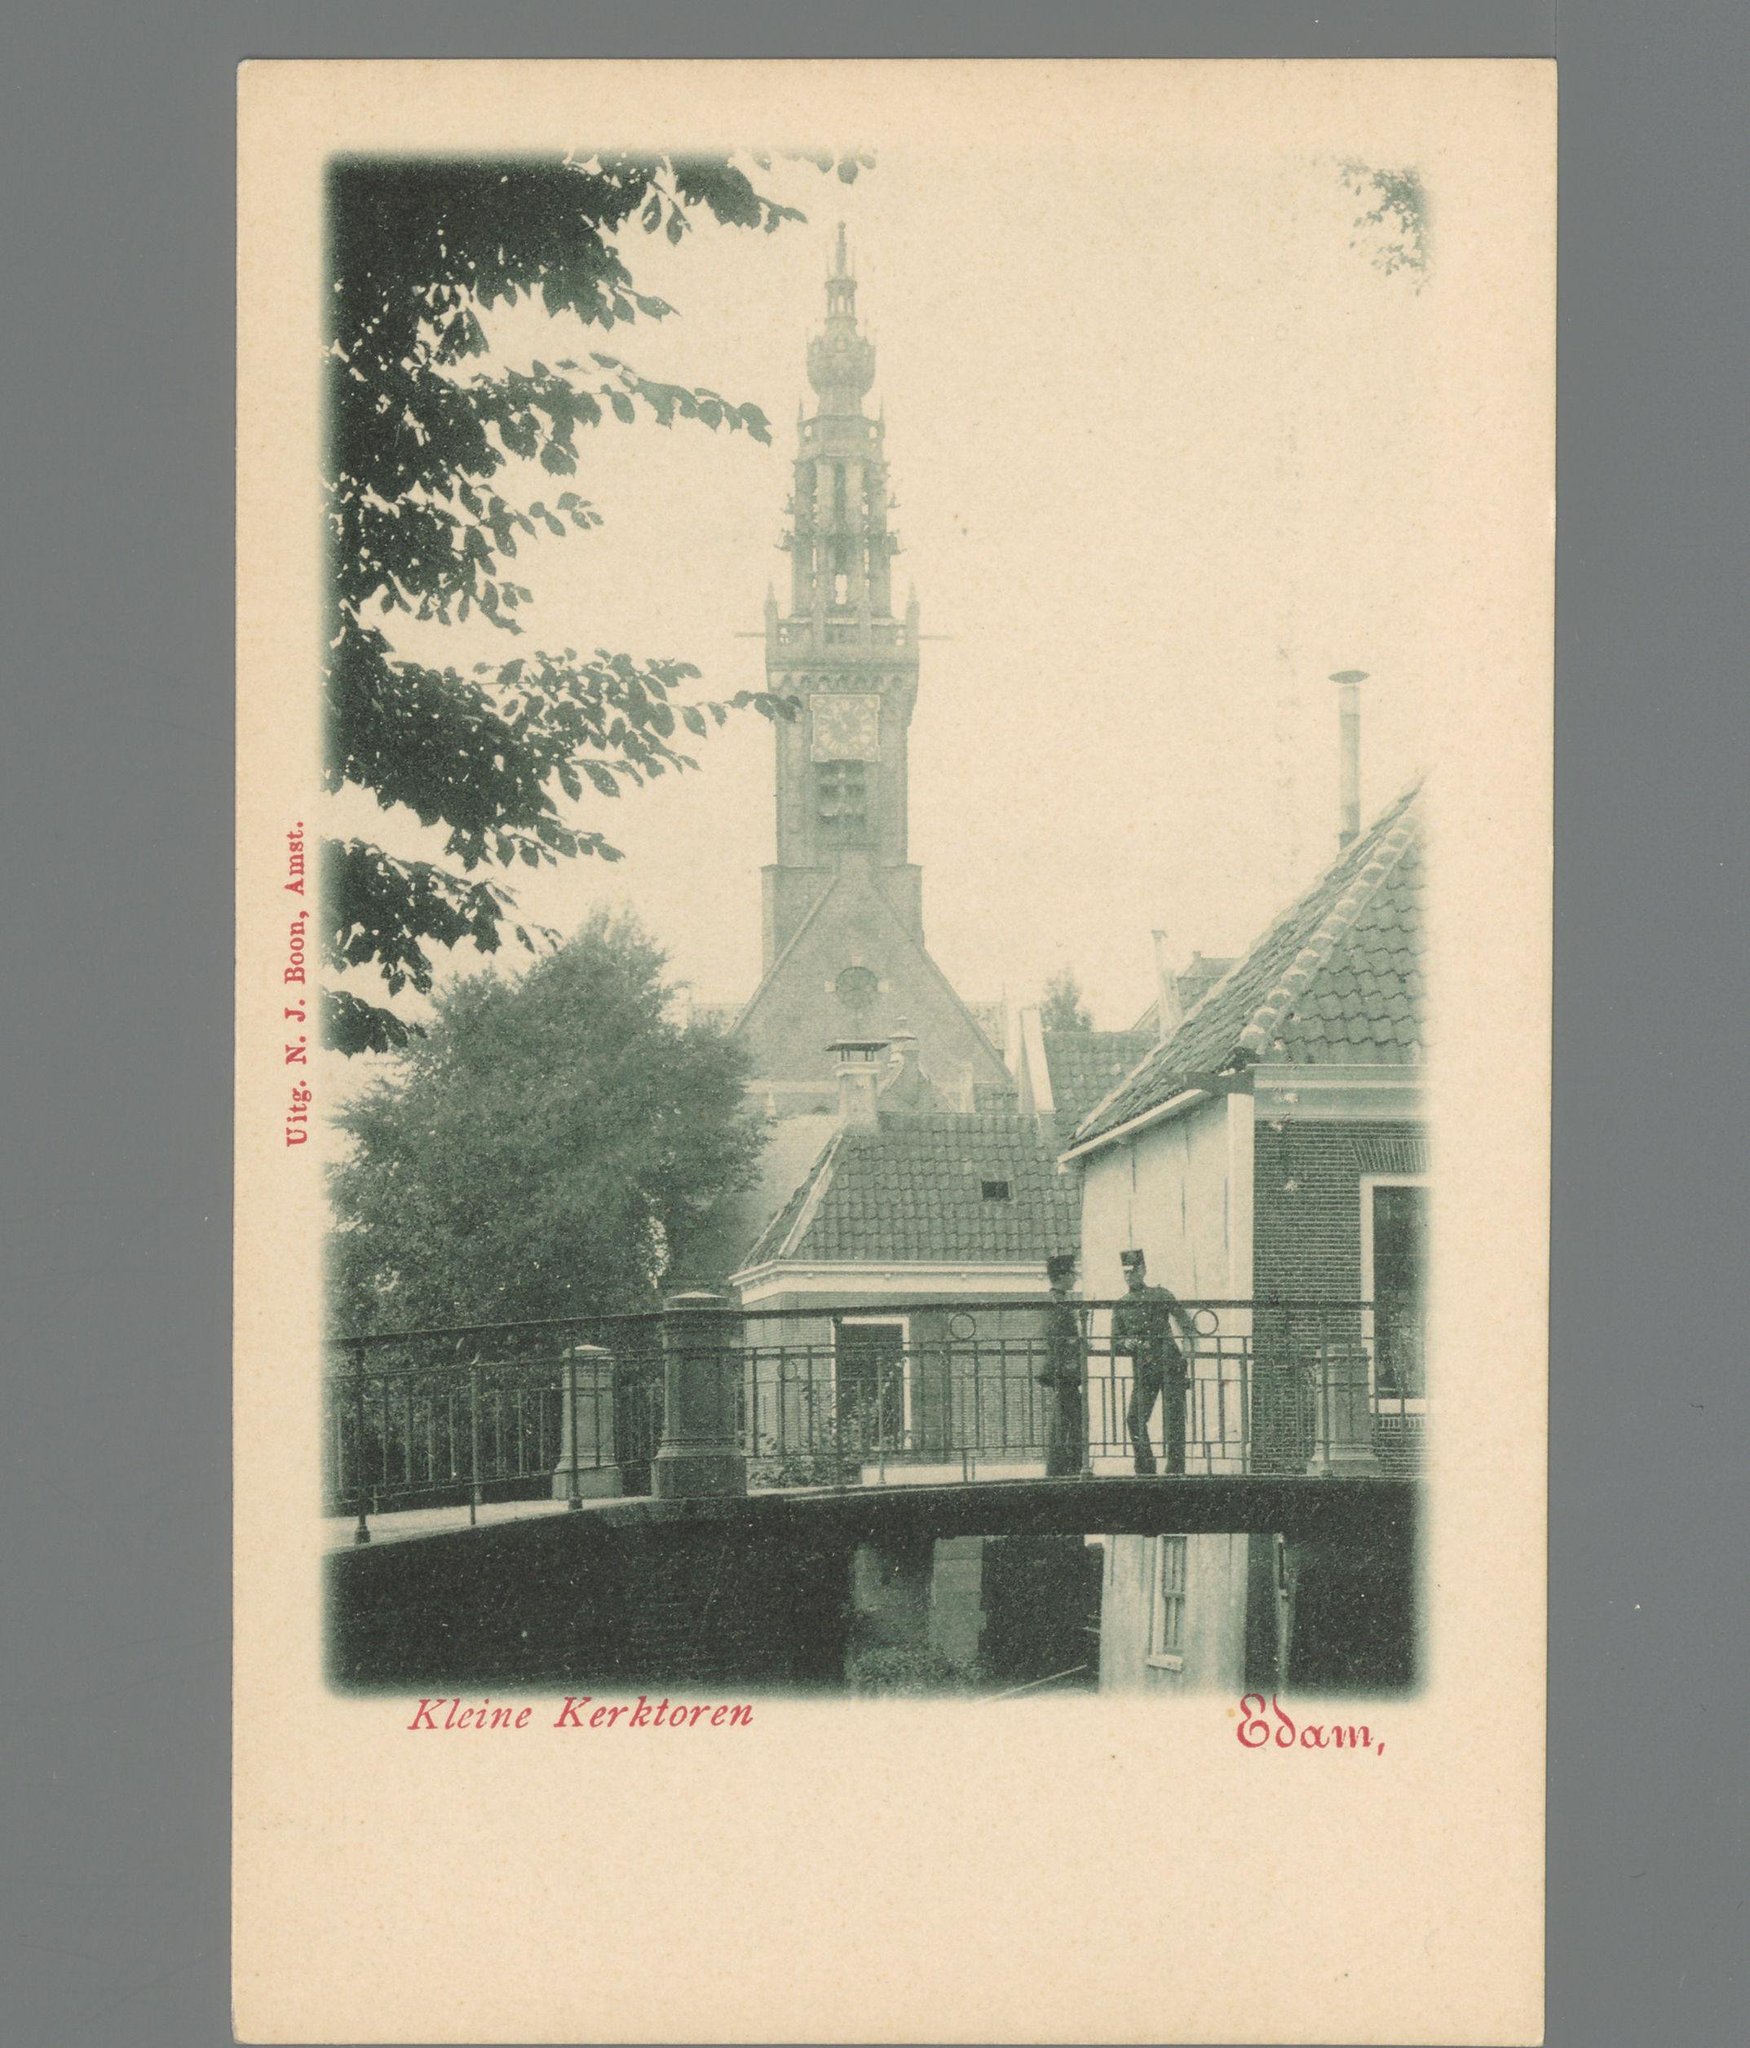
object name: ansichtkaart, prentbriefkaart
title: Kleine kerktoren. Edam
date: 1897-1905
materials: cardboard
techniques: photograph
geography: edam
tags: city-view, and landscape with man-made constructions, church (exterior), bridge in city across river, canal, etc.